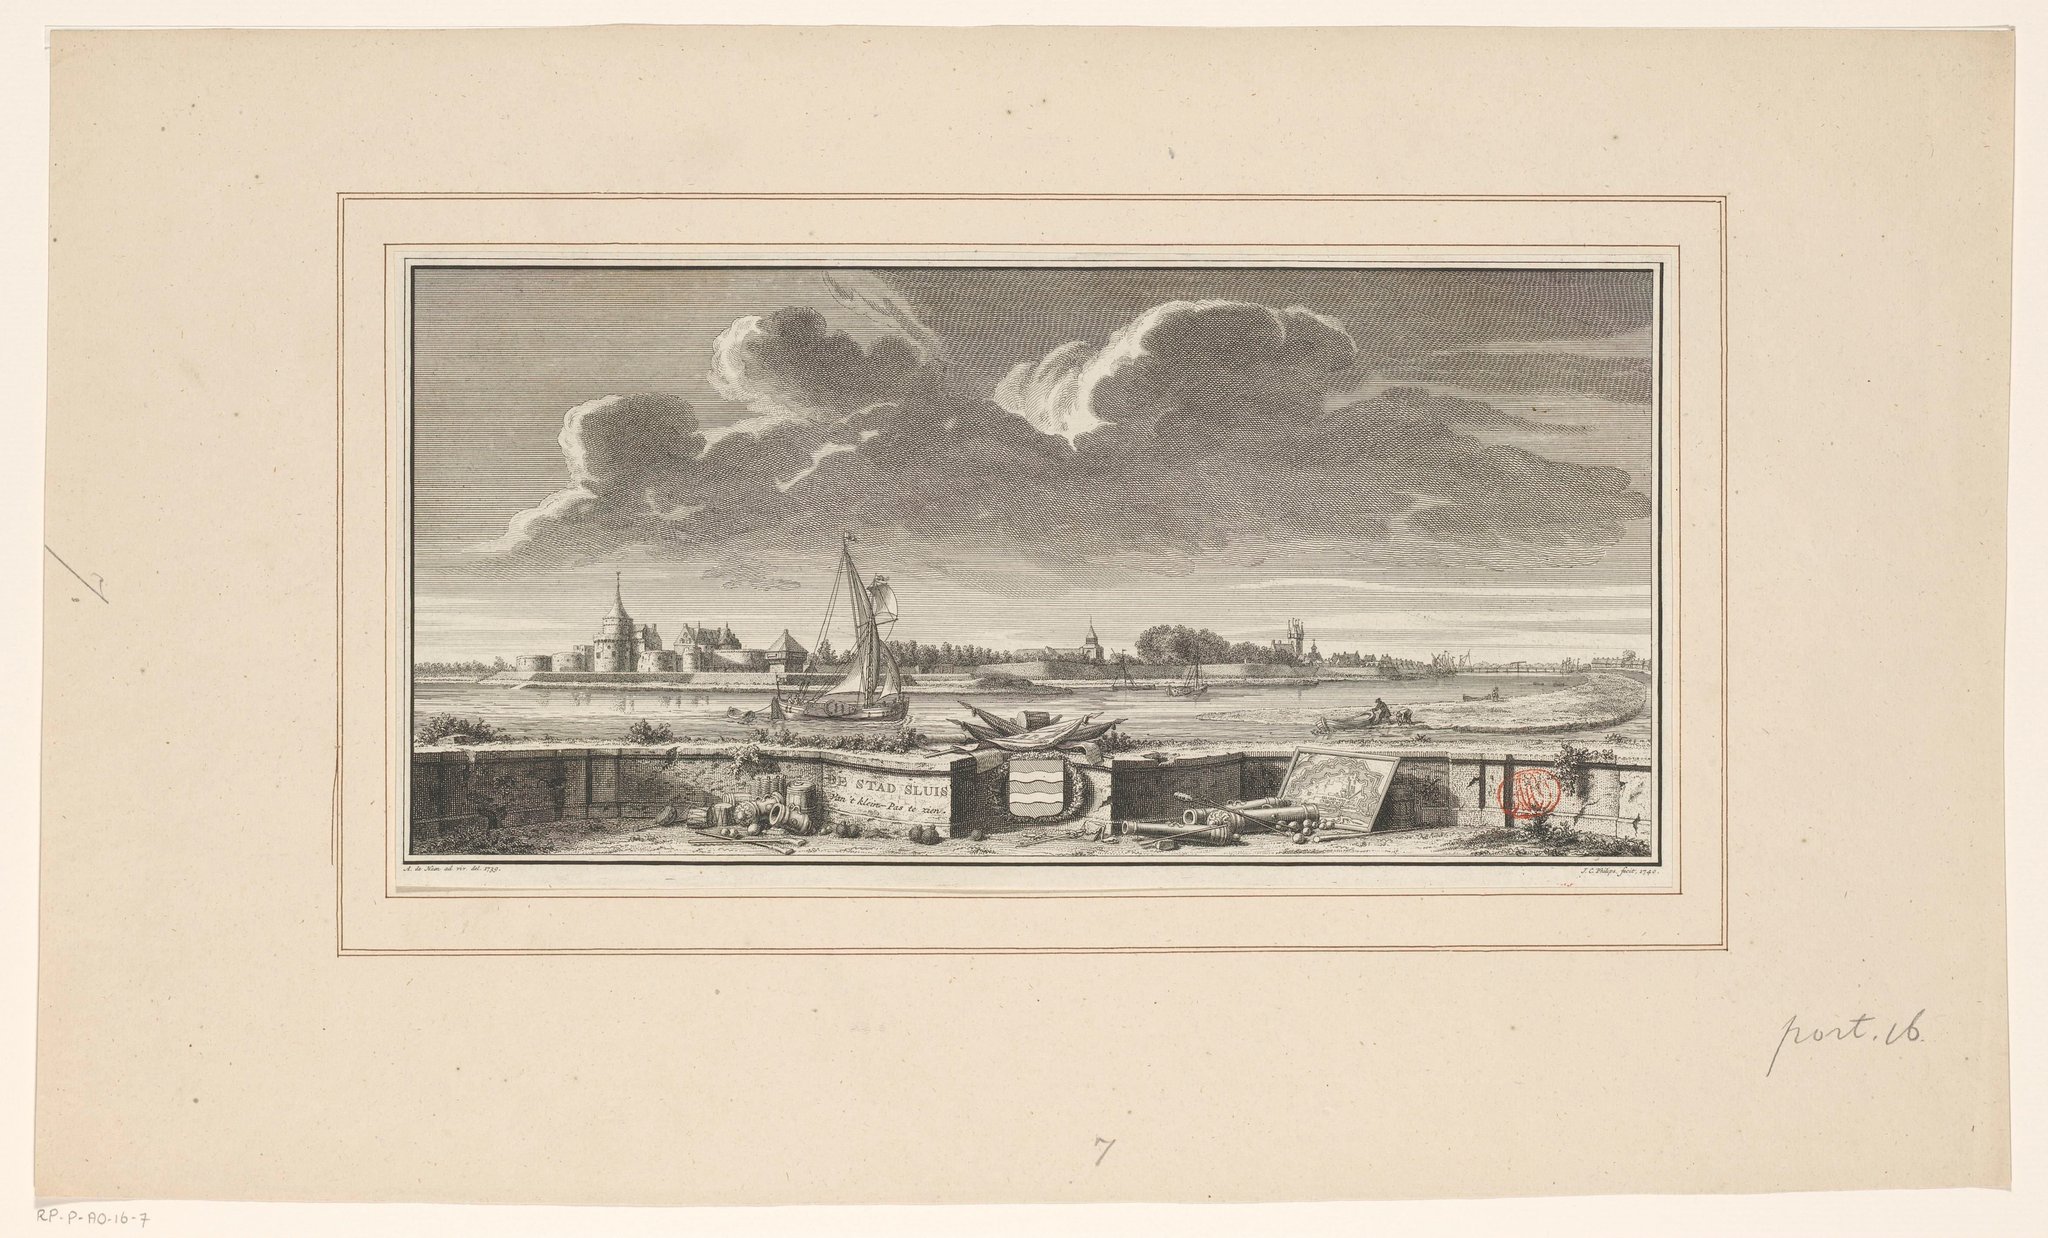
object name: print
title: De Stad Sluis van 't kleine-Pas te zien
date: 1740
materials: paper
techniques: engraving, etching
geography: amsterdam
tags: coat of arms (as symbol of the state, etc.) (+ city; municipal), prospect of city, town panorama, silhouette of city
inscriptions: collector's mark: Lugt 195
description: Gezicht op Sluis vanaf de kleine Pas. Op de voorgrond een muur waar oorlogstuig voor ligt. In het midden van de muur het stadswapen van Sluis, omringd door een krans.